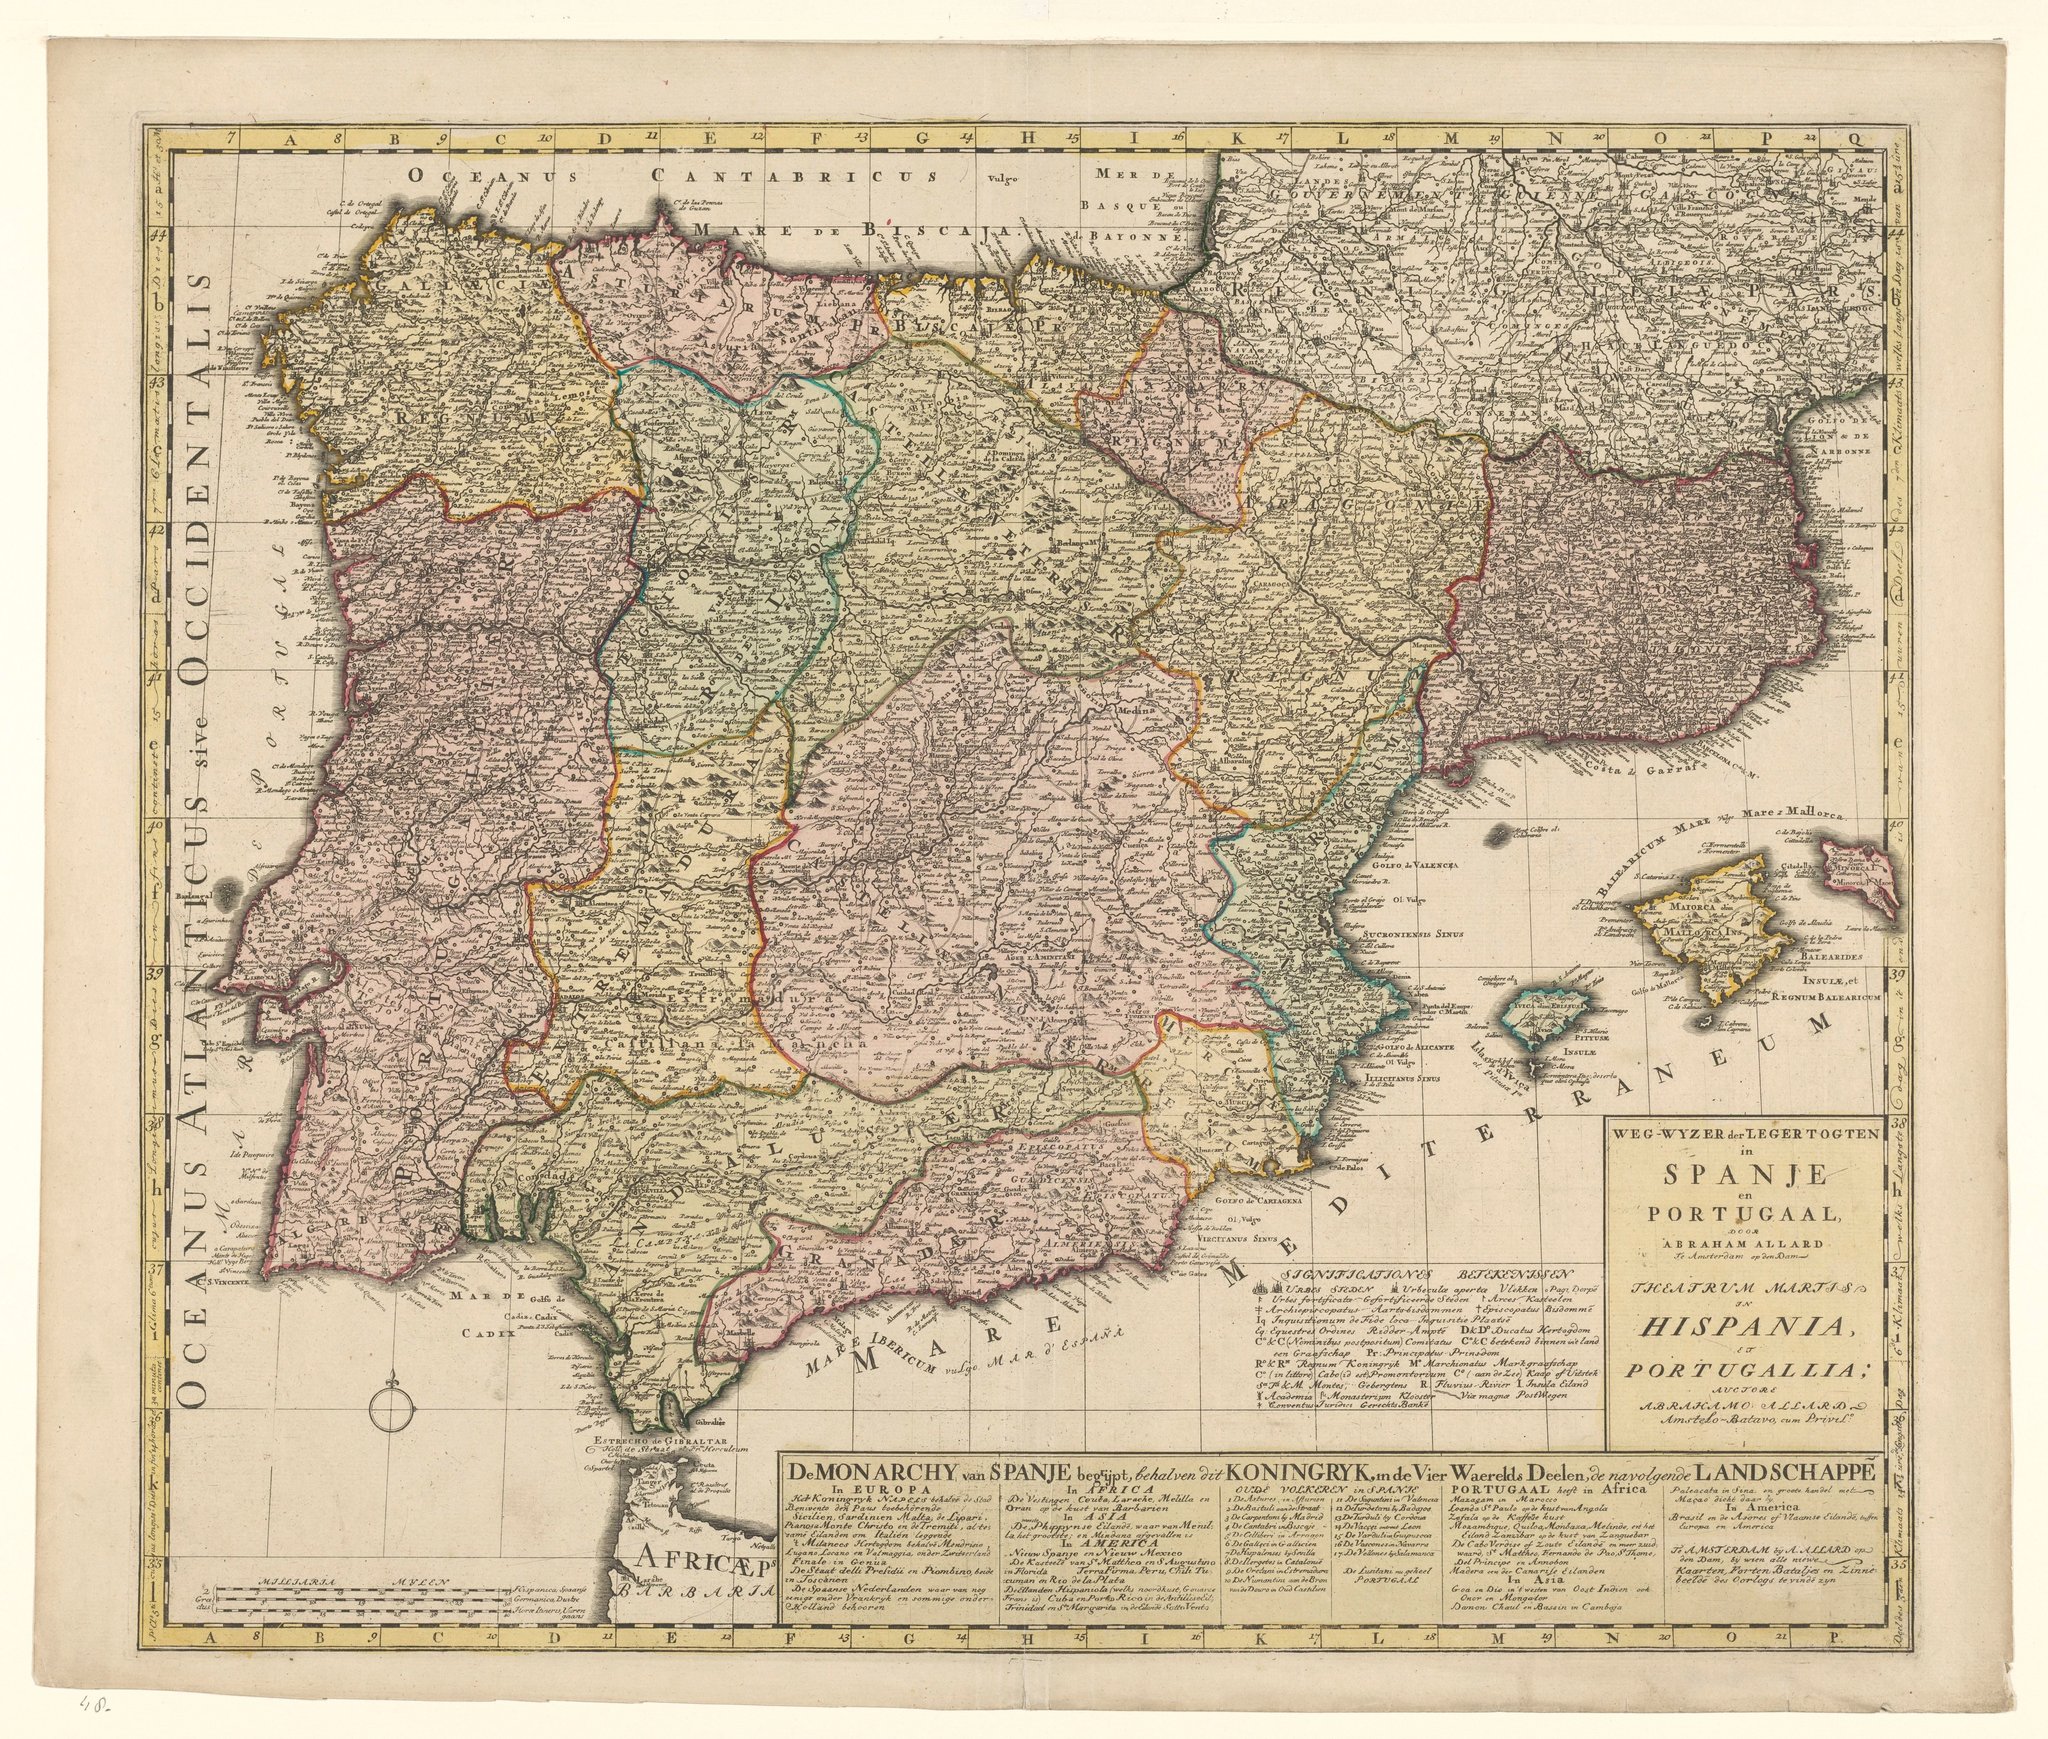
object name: map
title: Kaart van Spanje en Portugal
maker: abraham allard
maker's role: print maker, publisher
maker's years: 1676-1725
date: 1675-1725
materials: paper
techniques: colour, engraving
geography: amsterdam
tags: maps of separate countries or regions, spain